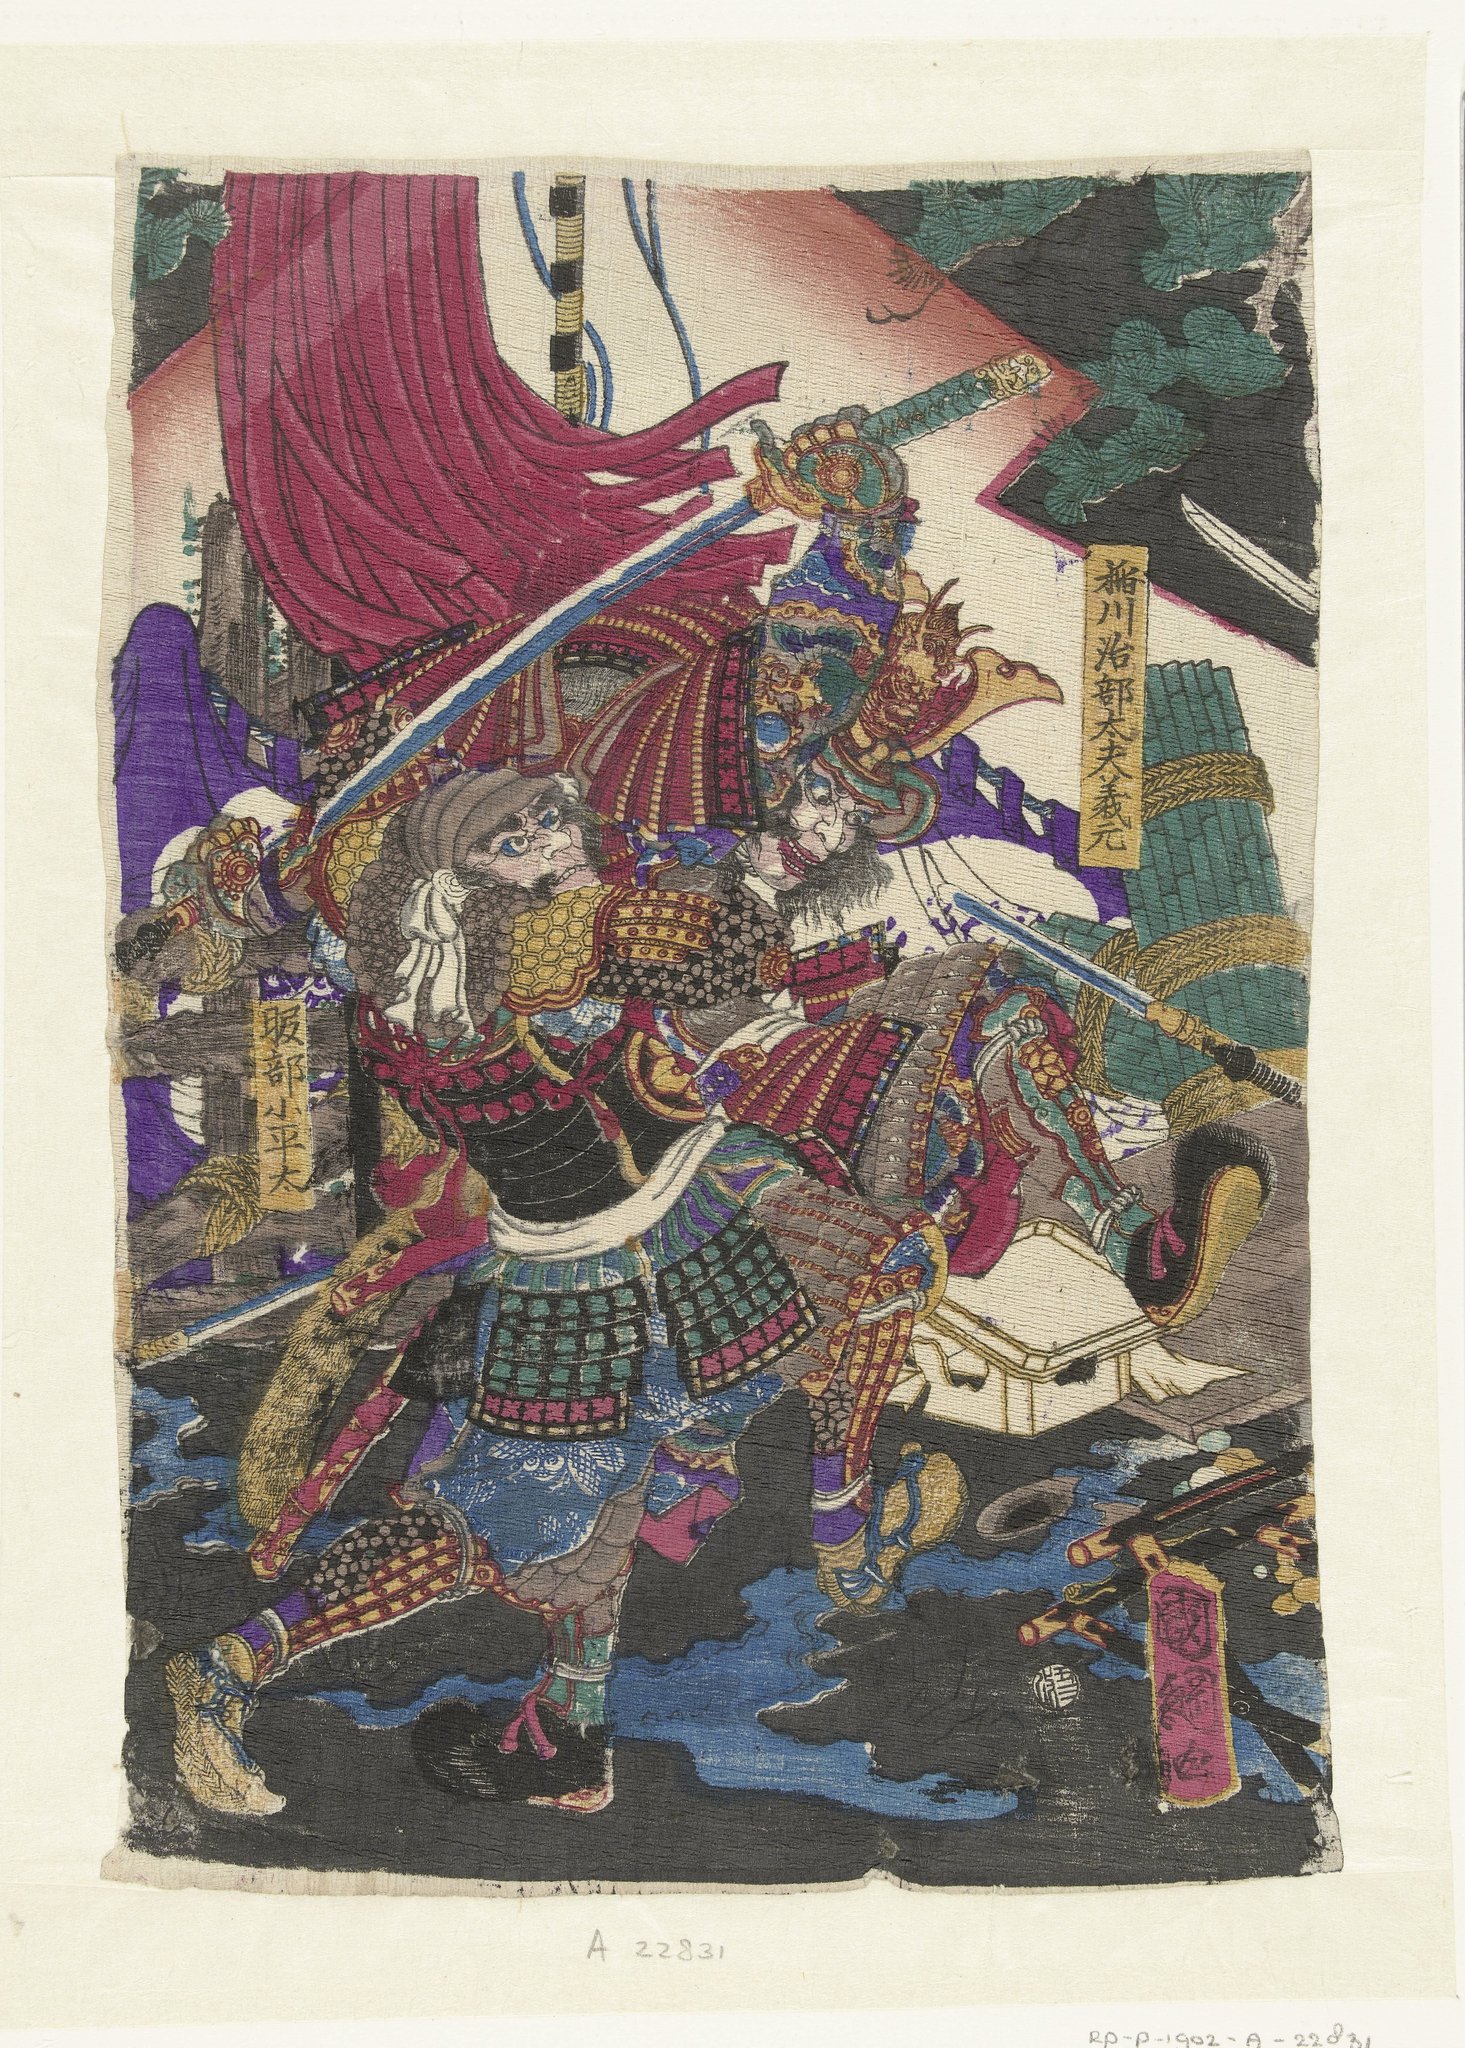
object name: print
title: Vechtende mannen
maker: utagawa kunitsuna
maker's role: print maker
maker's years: 1805-1868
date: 1865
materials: paper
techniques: woodcut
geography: japan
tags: hacking and thrusting weapons: sword (+ during the battle)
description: Twee samoerai, vechtend met zwaarden; links- en rechtsboven pijnboomtakken.